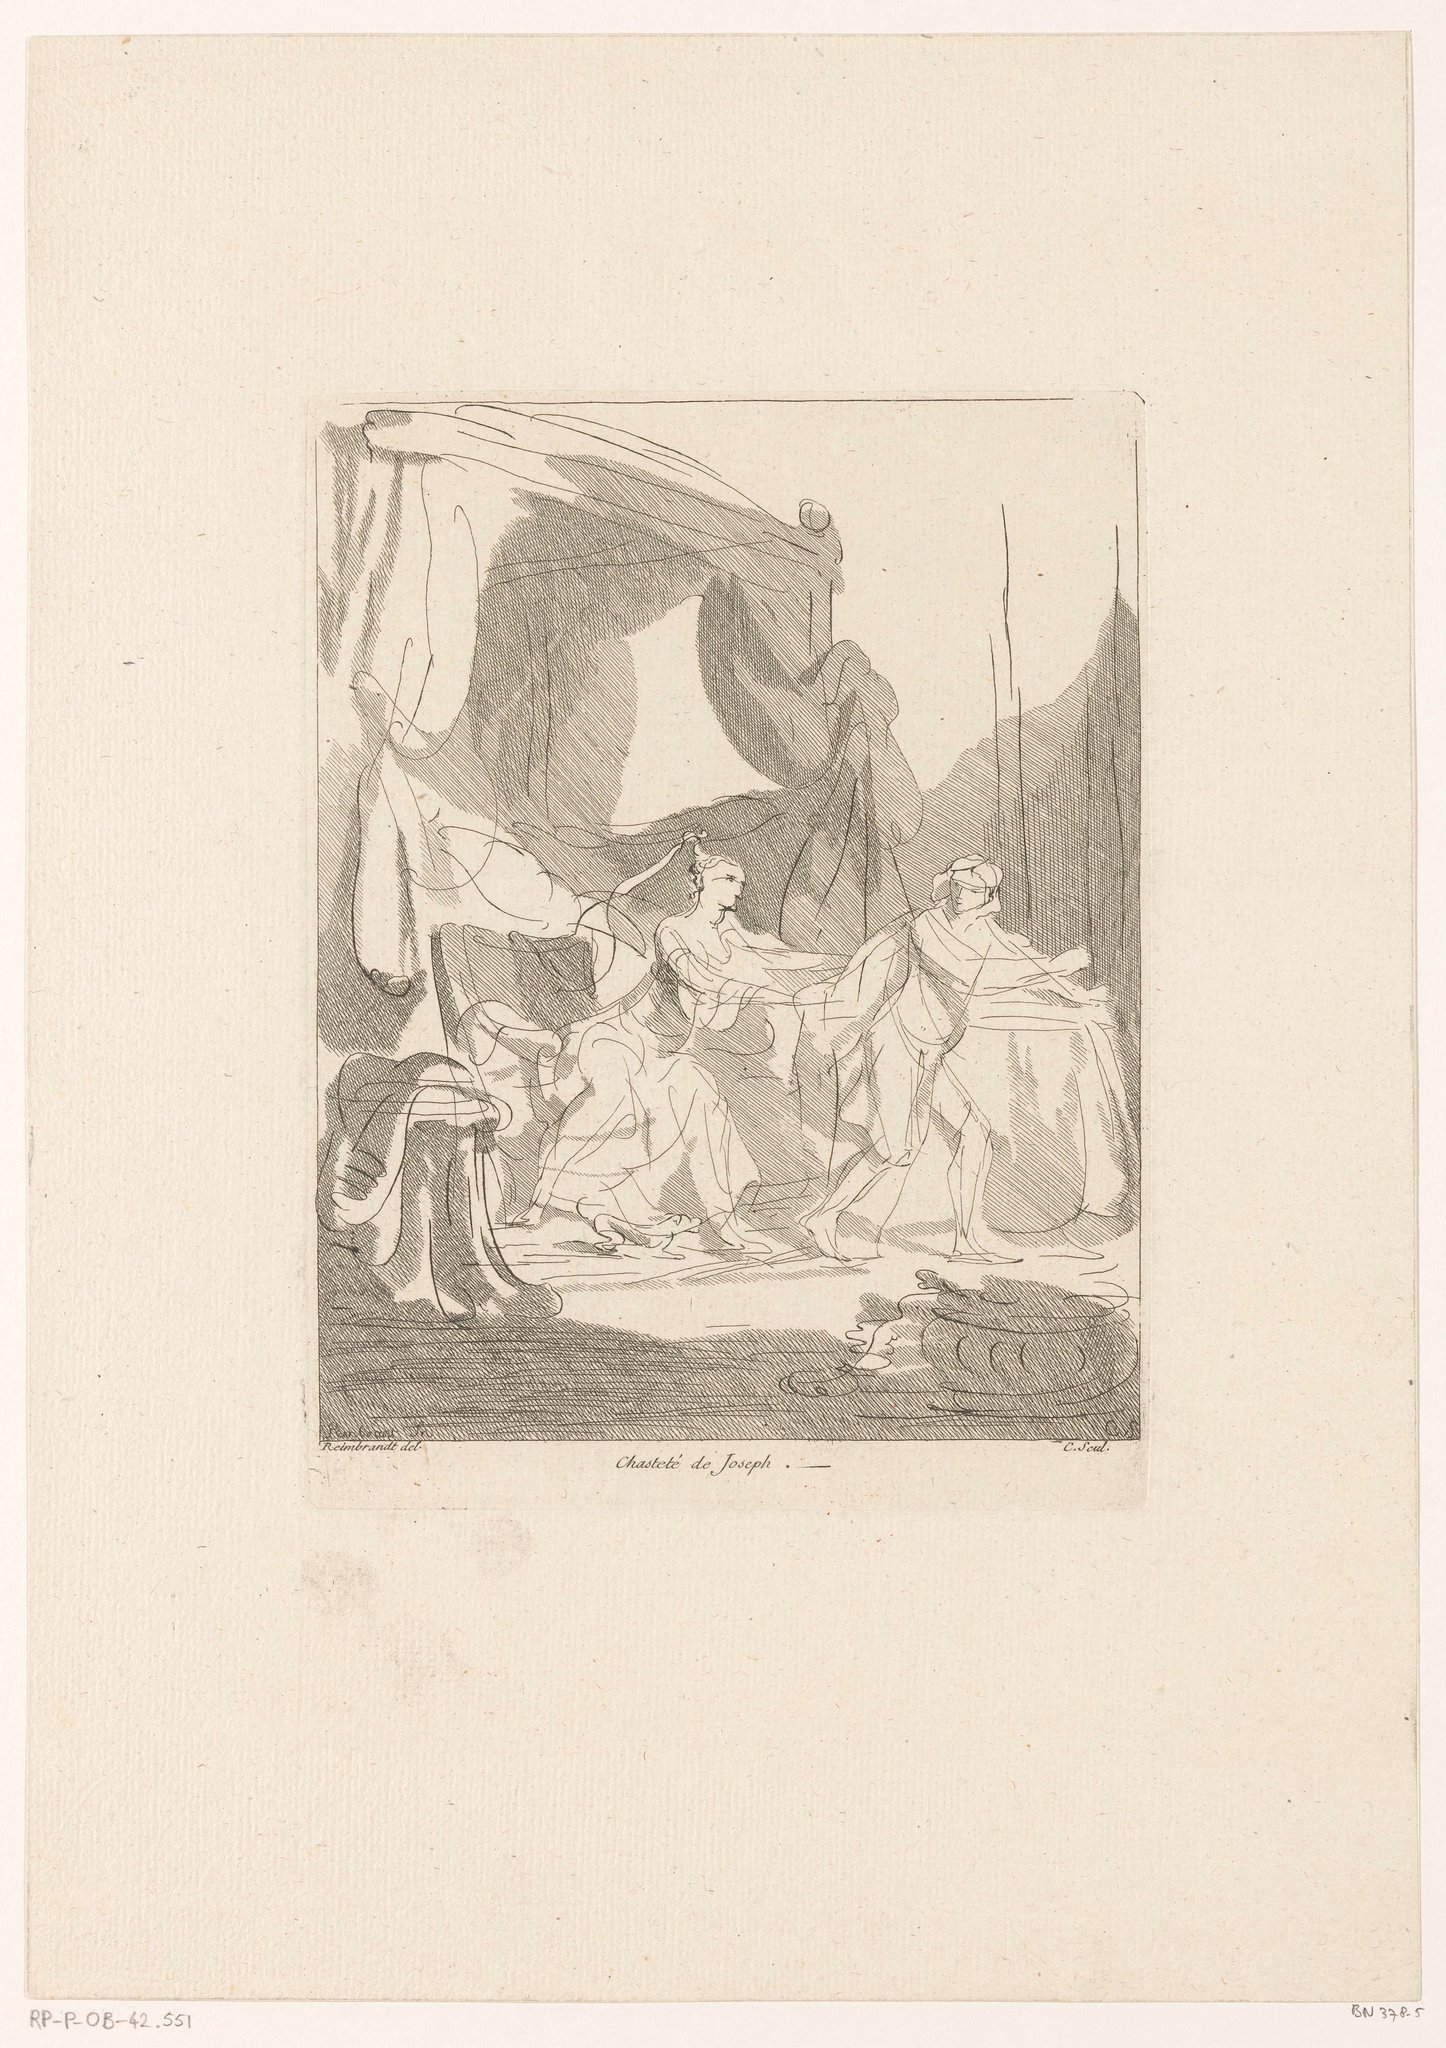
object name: print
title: Histoire de Joseph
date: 1702-1753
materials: paper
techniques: etching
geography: france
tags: potiphar's wife catches joseph by his robe, usually while lying in bed; joseph escapes leaving his cloak behind in her hands (possibly with a naked child lying in a crib), genesis: the story of joseph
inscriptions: collector's mark: Lugt 240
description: Maakt deel uit van een serie getiteld: "Histoire de Joseph", bestaande uit tien platen naar tekeningen, voorheen toegeschreven aan Rembrandt, maar tegenwoordig gecatalogiseerd als tekeningen in de manier van Rembrandt, waarbij de naam Gerbrandt van den Eeckhout wordt gesuggereerd. De serie wordt genoemd in een veilingcatalogus van Coypel in 1753. In 1757 werd de serie uitgegeven door Jean Néaulme in Amsterdam.